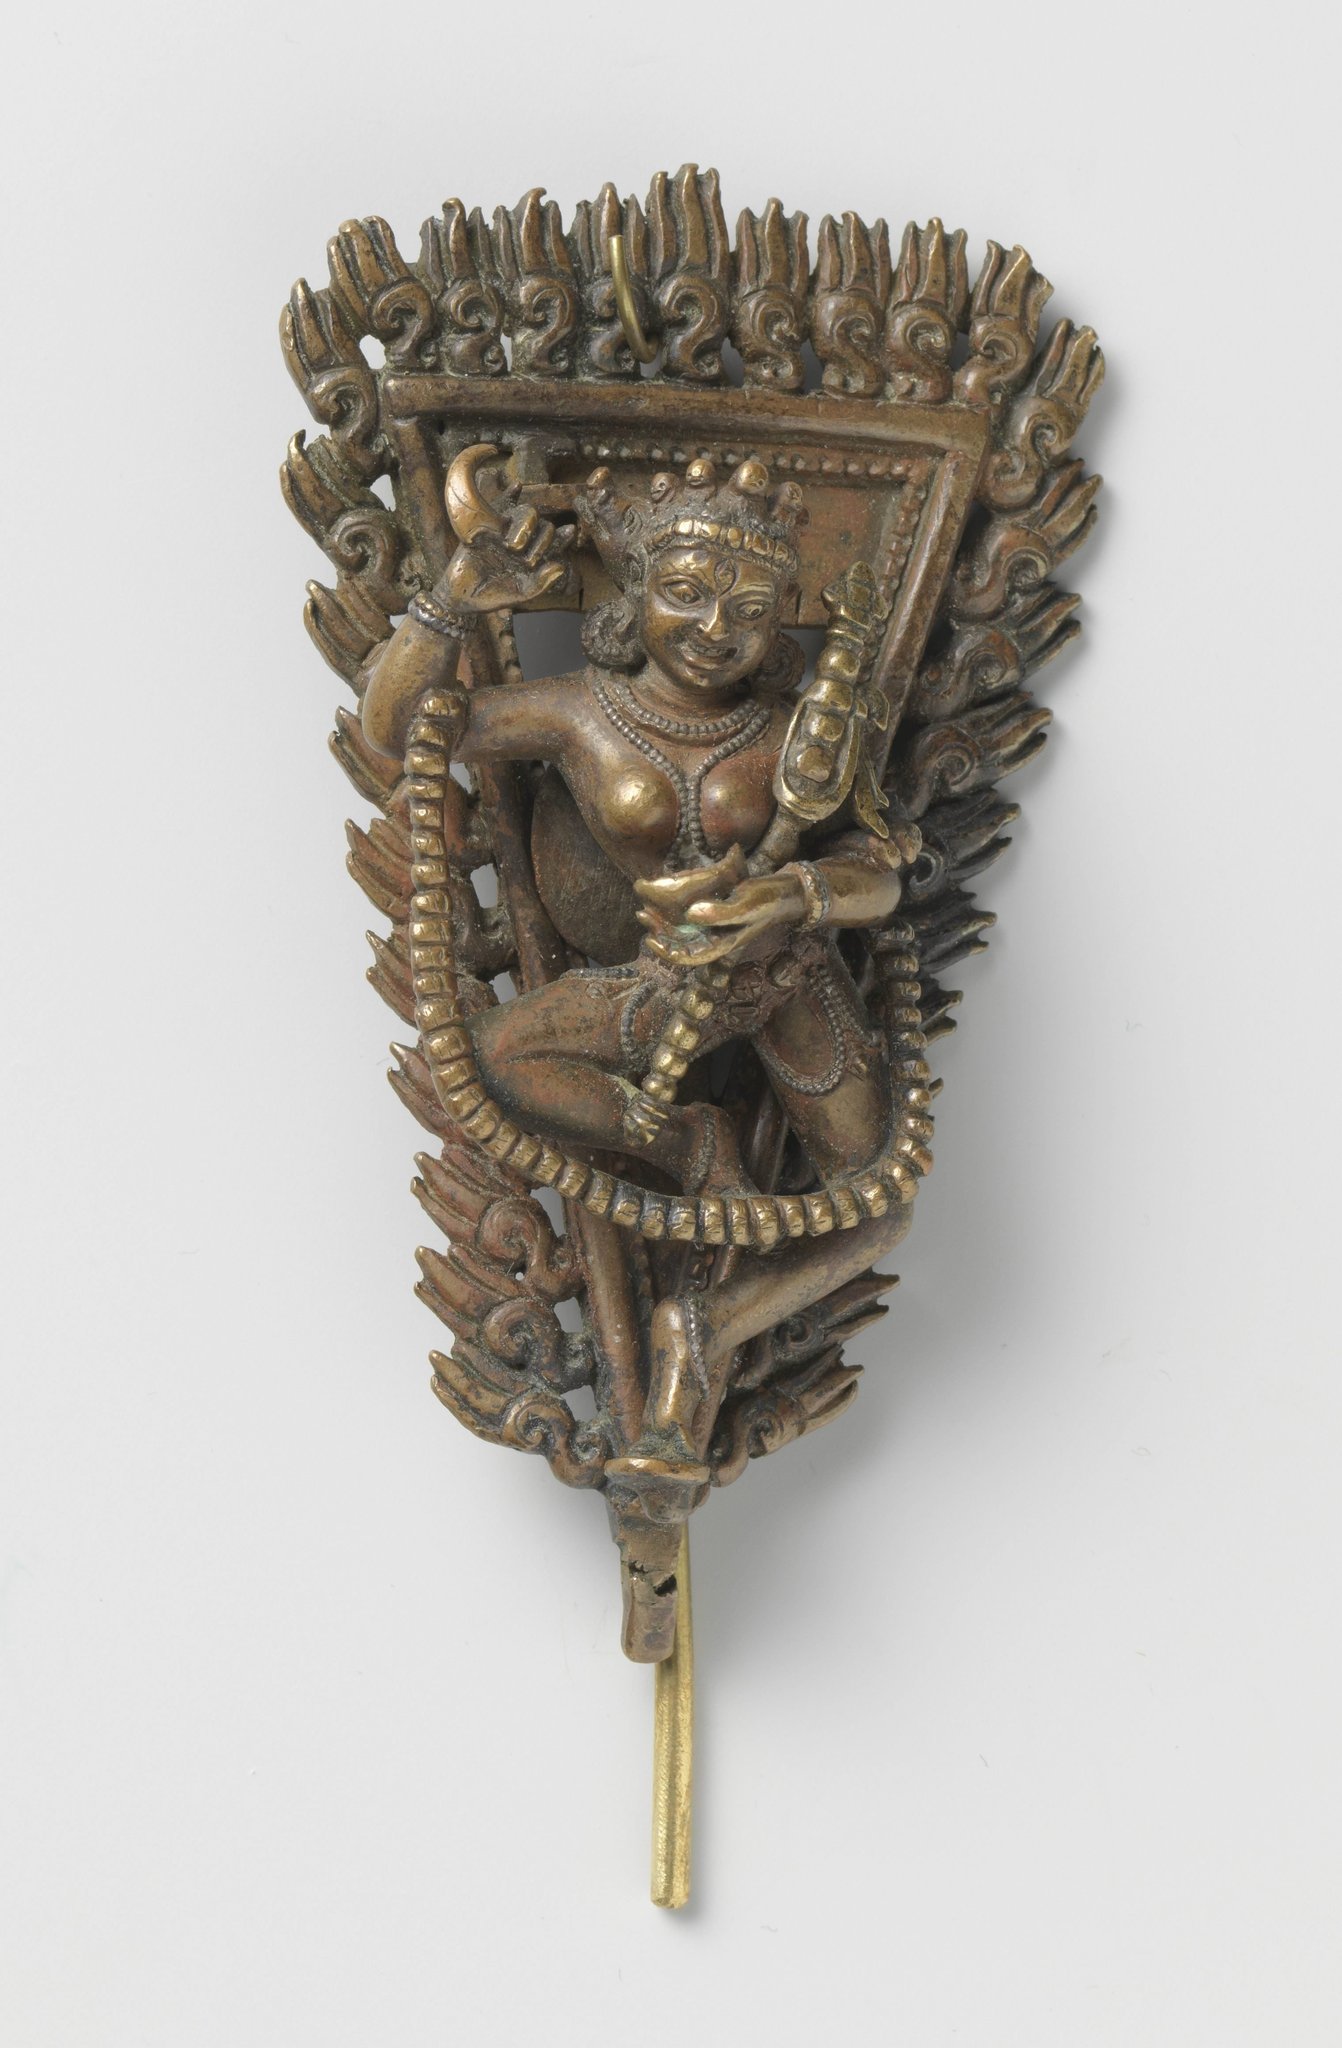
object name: sculpture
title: Vajravarahi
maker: Anonymous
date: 1100-1200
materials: brass, bronze, silver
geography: tibet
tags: representations ~ goddesses, demi-goddesses, heroines etc. (hinduism, buddhism or jainism)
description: This fierce goddess plays an important role in Tantric Buddhism. Her demonic characteristics are effectively expressed by her attributes: a staff topped by skulls, a curved knife and a skull bowl.